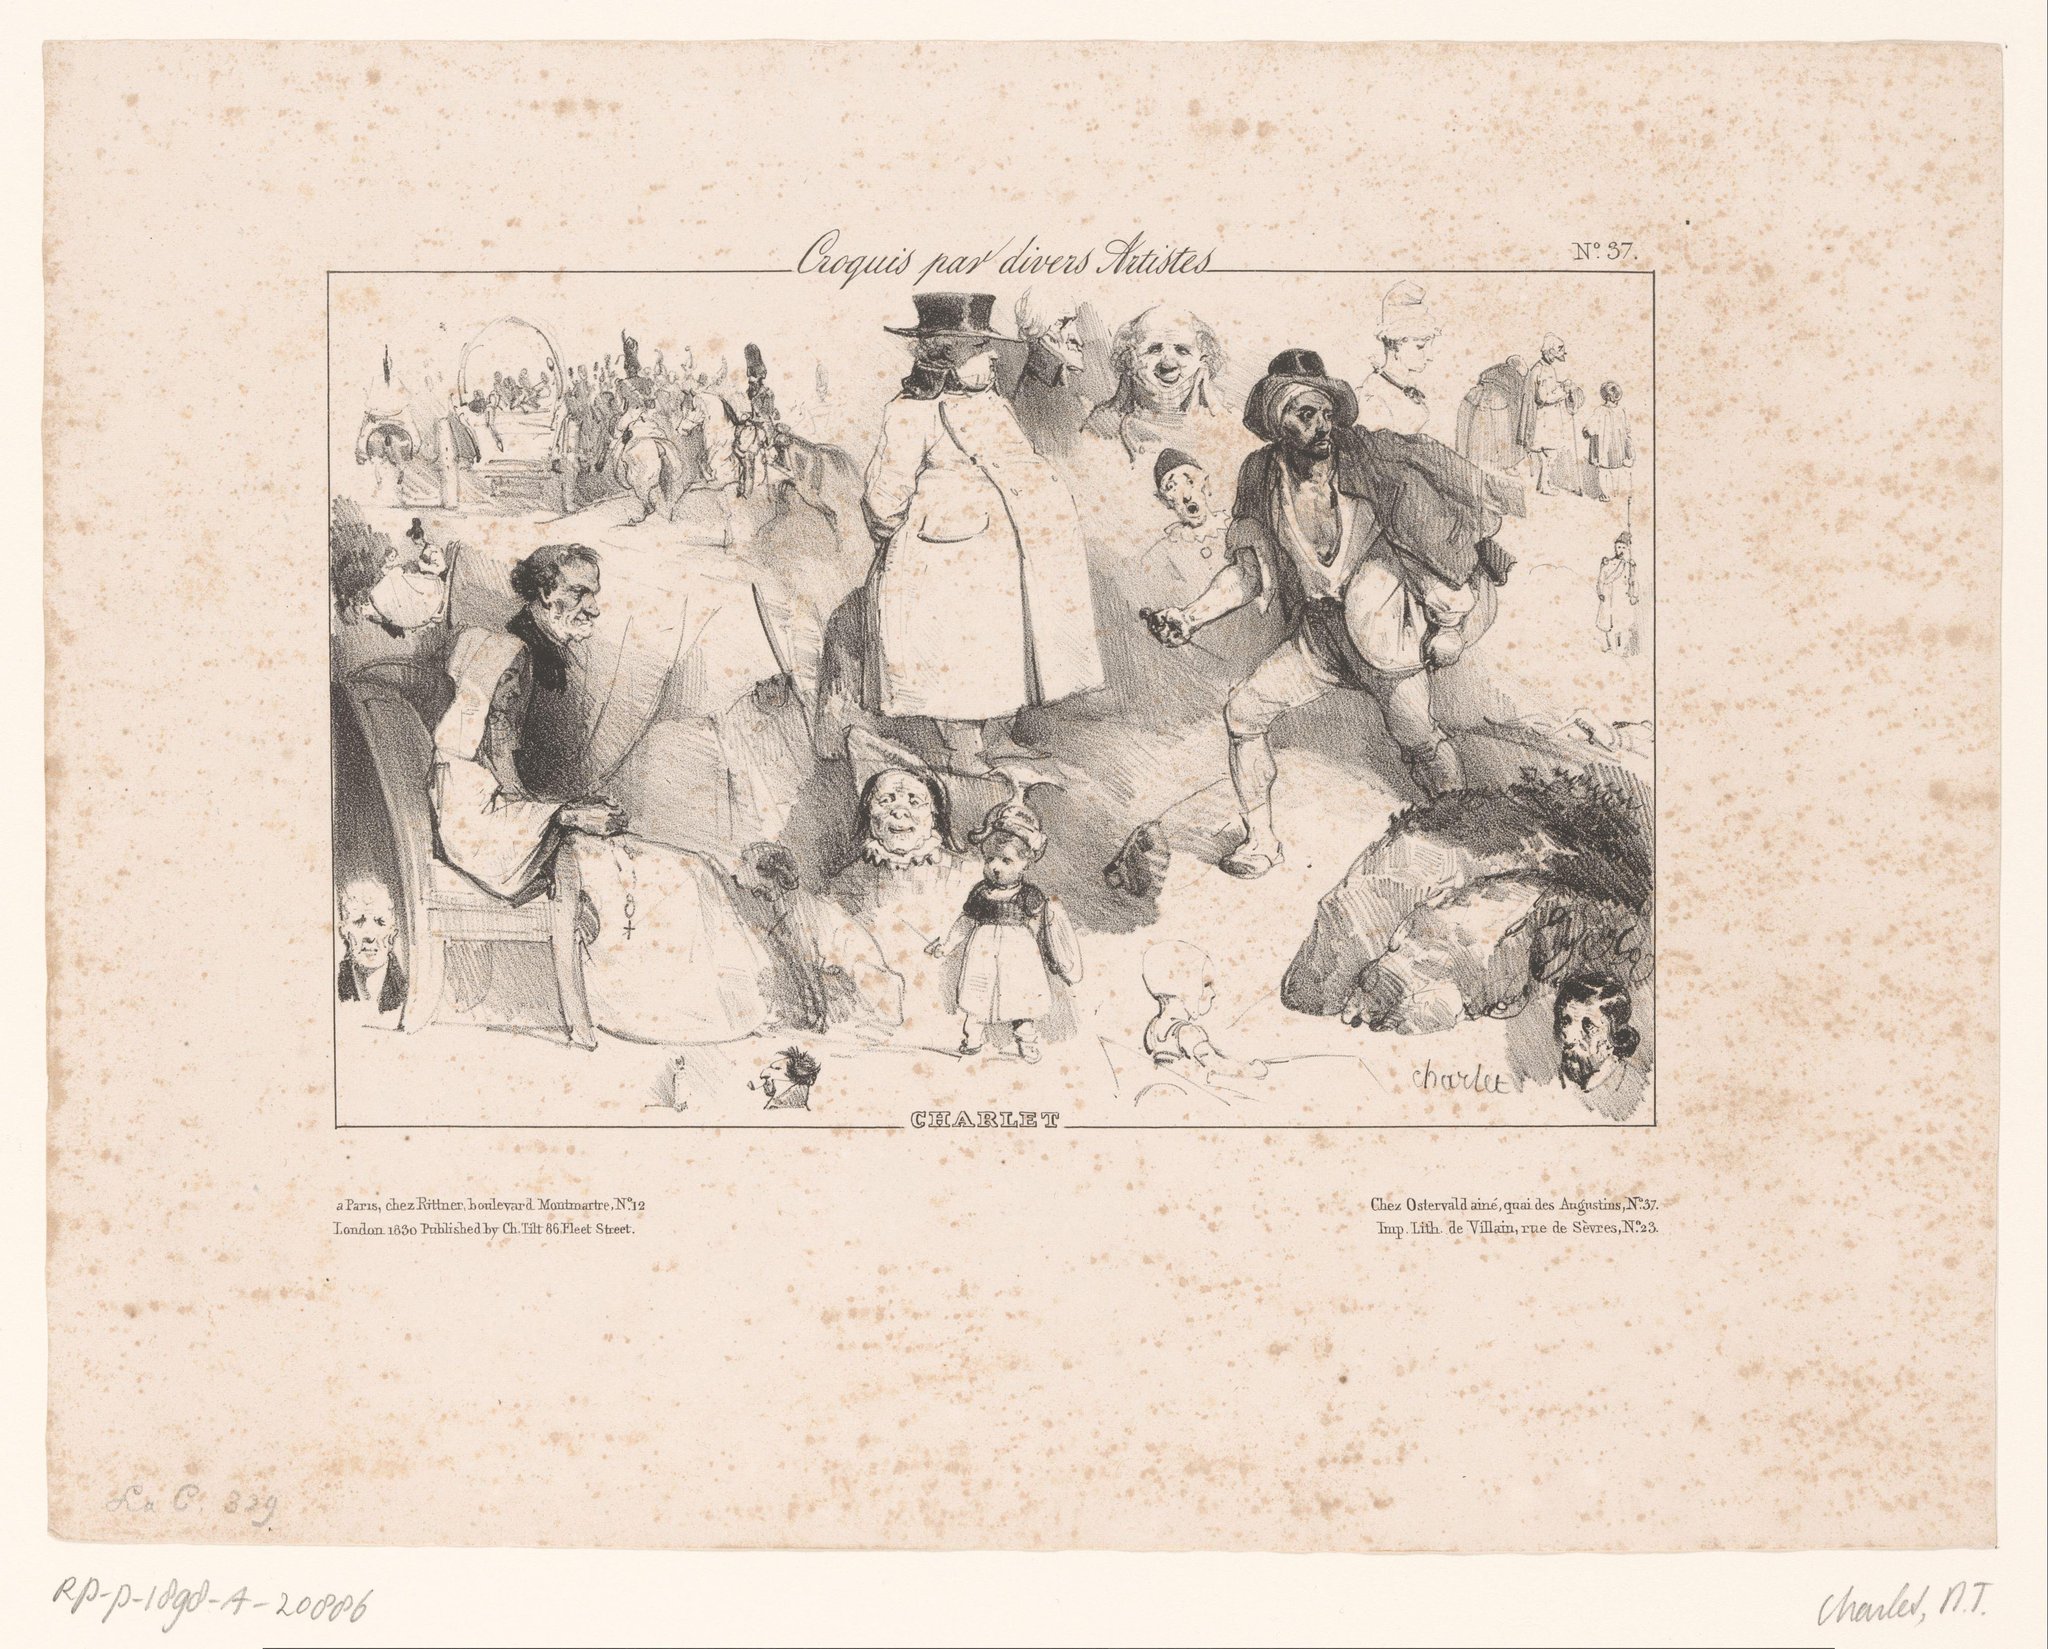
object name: print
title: Croquis par divers artistes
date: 1830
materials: paper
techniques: lithograph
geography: paris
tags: nun(s), robber, clown, tot, toddler ~ the ages of man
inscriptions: collector's mark: Lugt 2228a